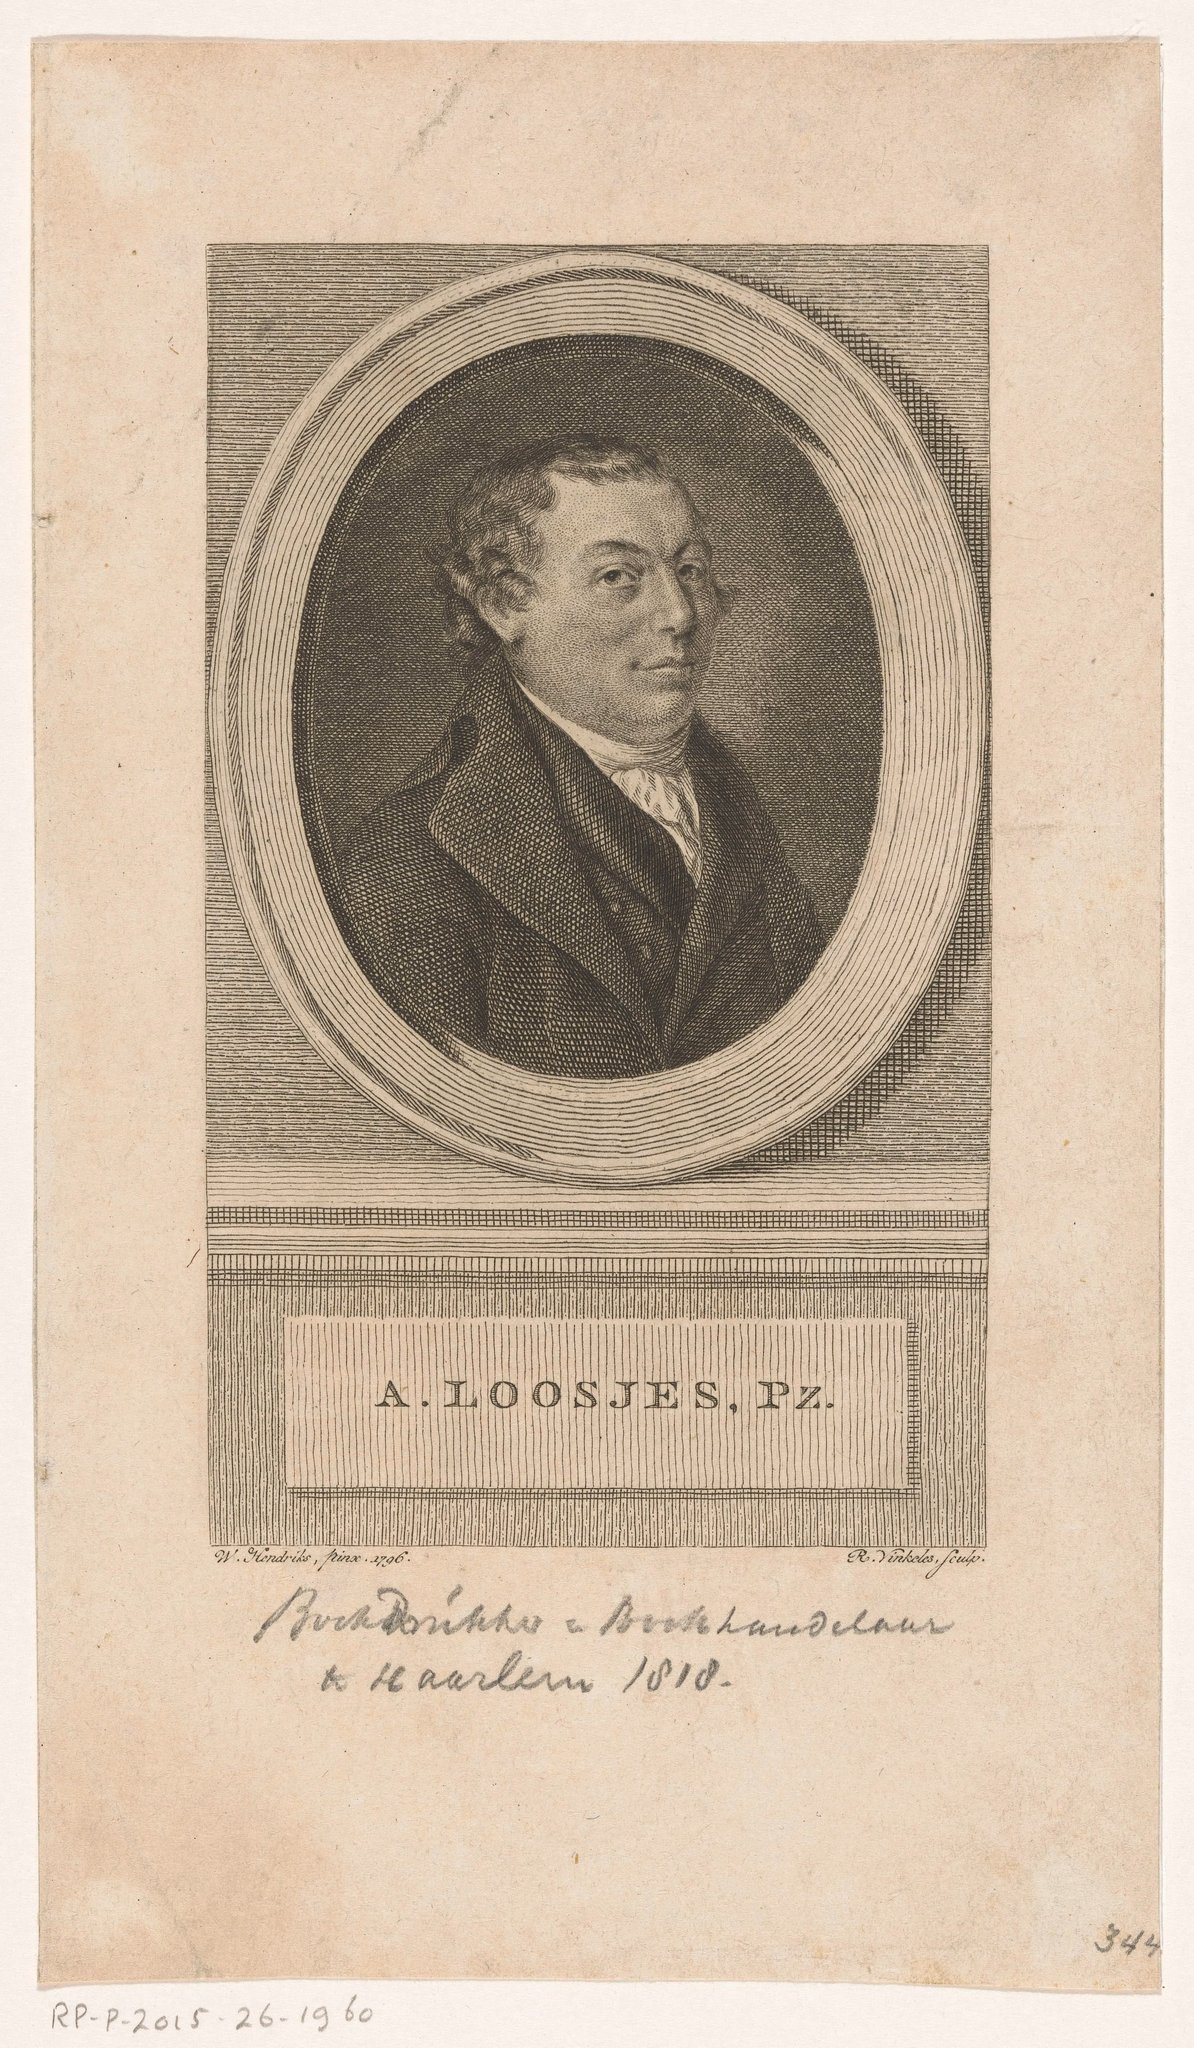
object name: print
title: Portret van Adriaan Pietersz. Loosjes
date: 1796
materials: paper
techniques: engraving, etching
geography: amsterdam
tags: haarlem, publisher, bookseller, adriaan pietersz. loosjes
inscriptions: collector's mark: Lugt 4780, collector's mark: Lugt 2228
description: Prent ook gebruikt als boekillustratie in: Wagenaar, Jan. Vaderlandsche historie, (...) ten vervolge van Wagenaars Vaderlandsche historie. Dl. 1-43. Amsterdam: Johannes Allart, 1786-1809.